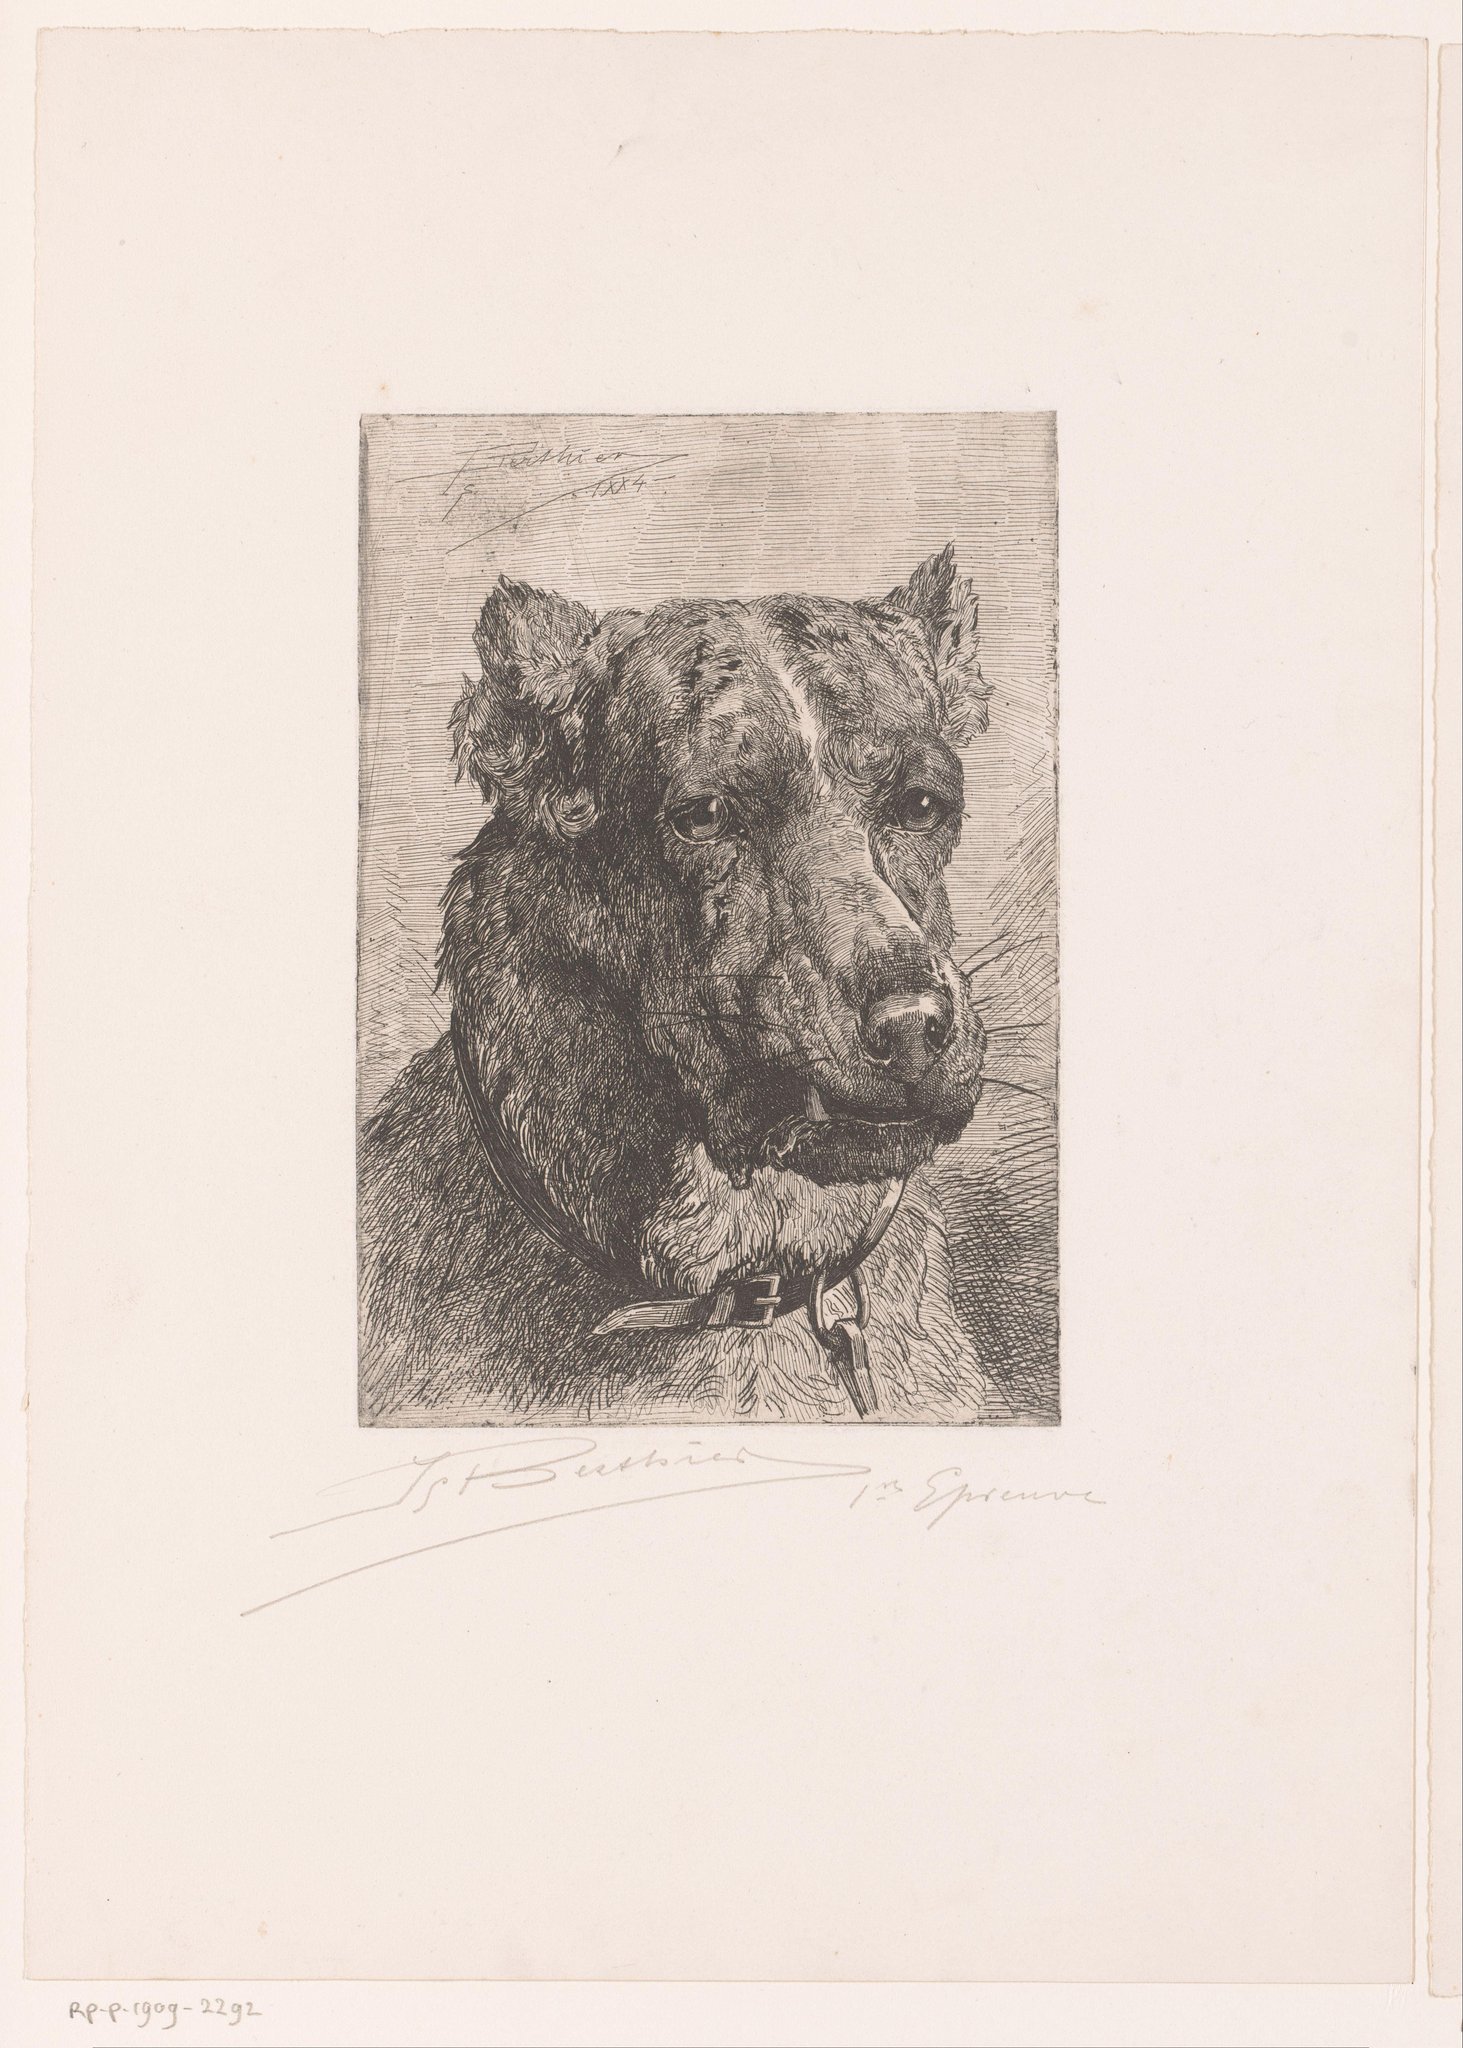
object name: print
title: Kop van een hond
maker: h. berthier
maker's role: print maker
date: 1884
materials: paper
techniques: etching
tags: dog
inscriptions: collector's mark: Lugt 2228, inscription: ‘1e Epreuve’